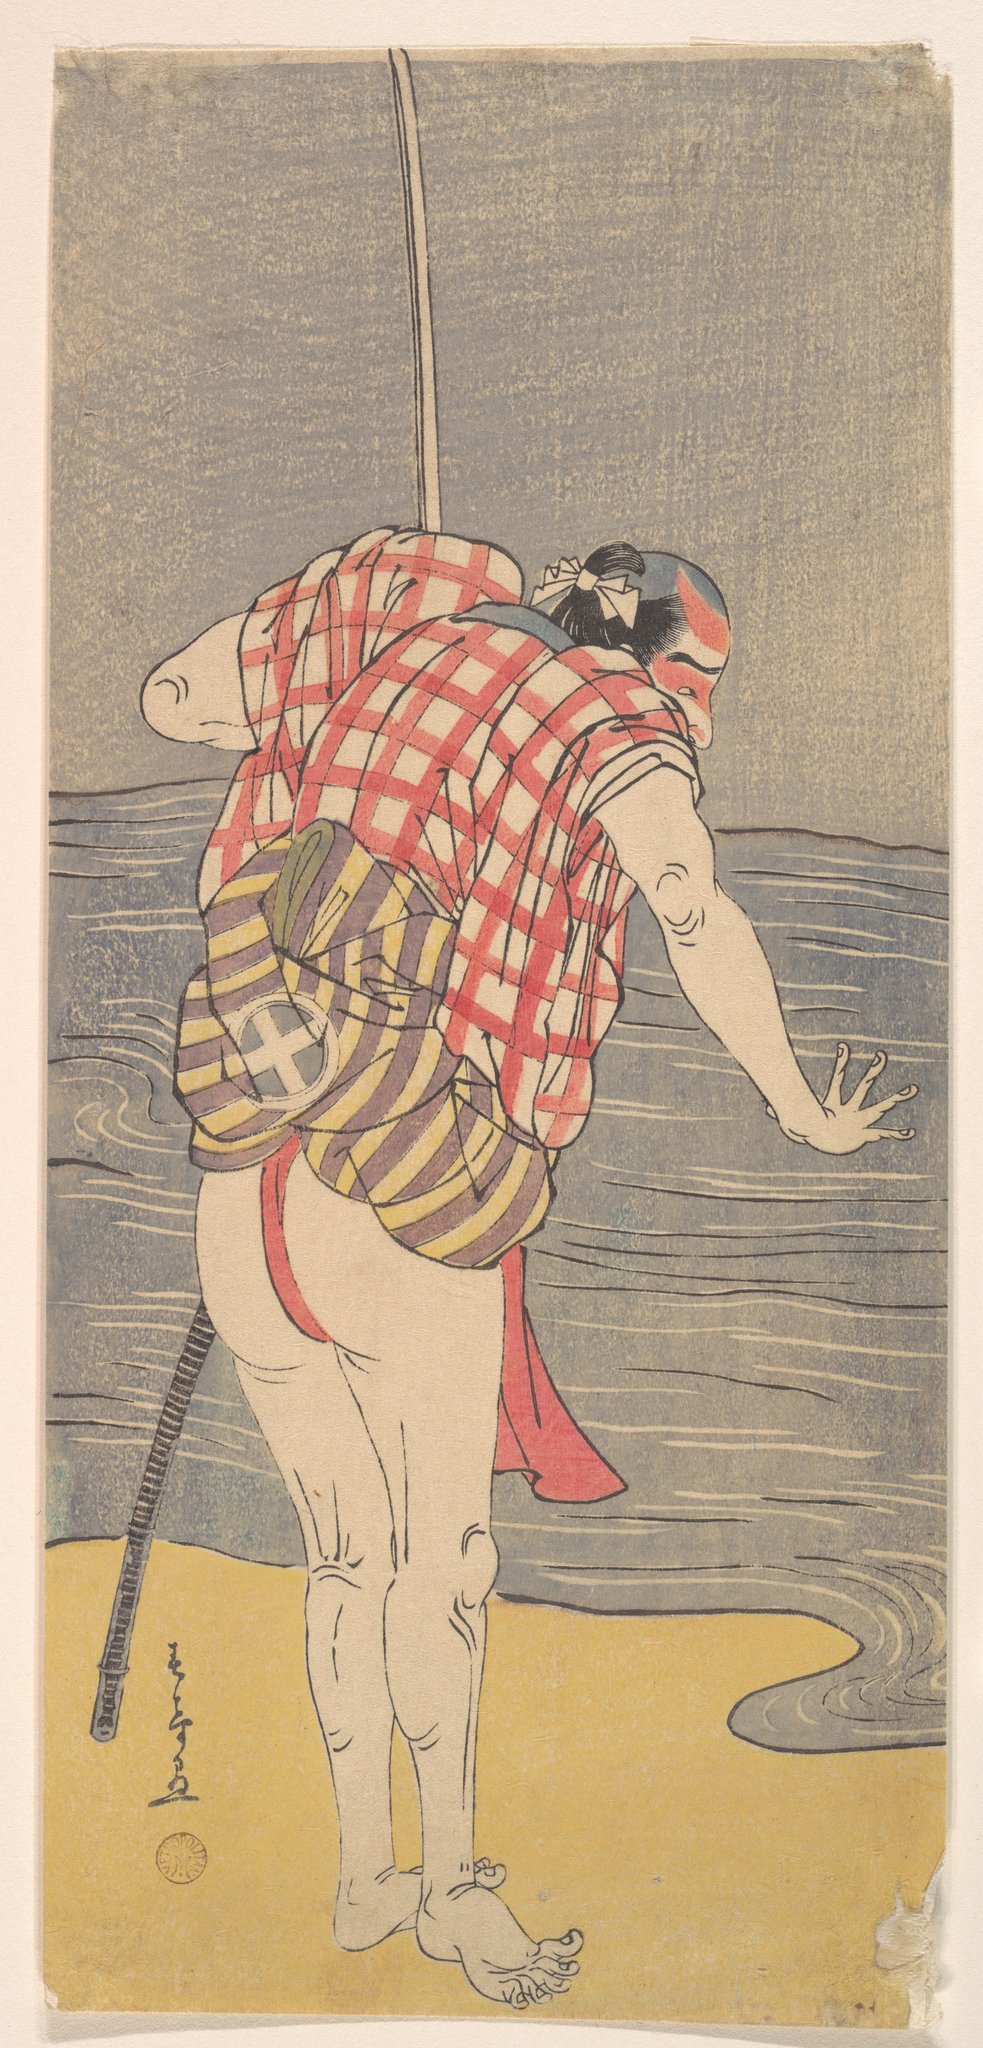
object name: woodblock print nishiki e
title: The Actor Otani Hiroemon III as Man Ready to Wade into the Sea with a Drawn Sword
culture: japanese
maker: katsukawa shunshō 勝川春章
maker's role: artist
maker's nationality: japanese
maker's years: 1726-1792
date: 1775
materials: ink, paper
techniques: nishiki e, woodblock print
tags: men,actors